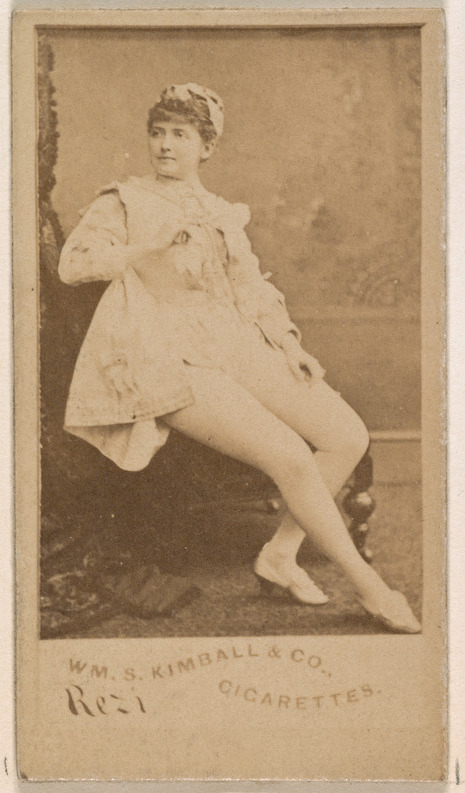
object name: photograph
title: Miss Rezi, from the Actresses series (N203) issued by Wm. S. Kimball & Co.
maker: william s. kimball & company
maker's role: publisher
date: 1889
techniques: color lithograph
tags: portraits,women,actresses